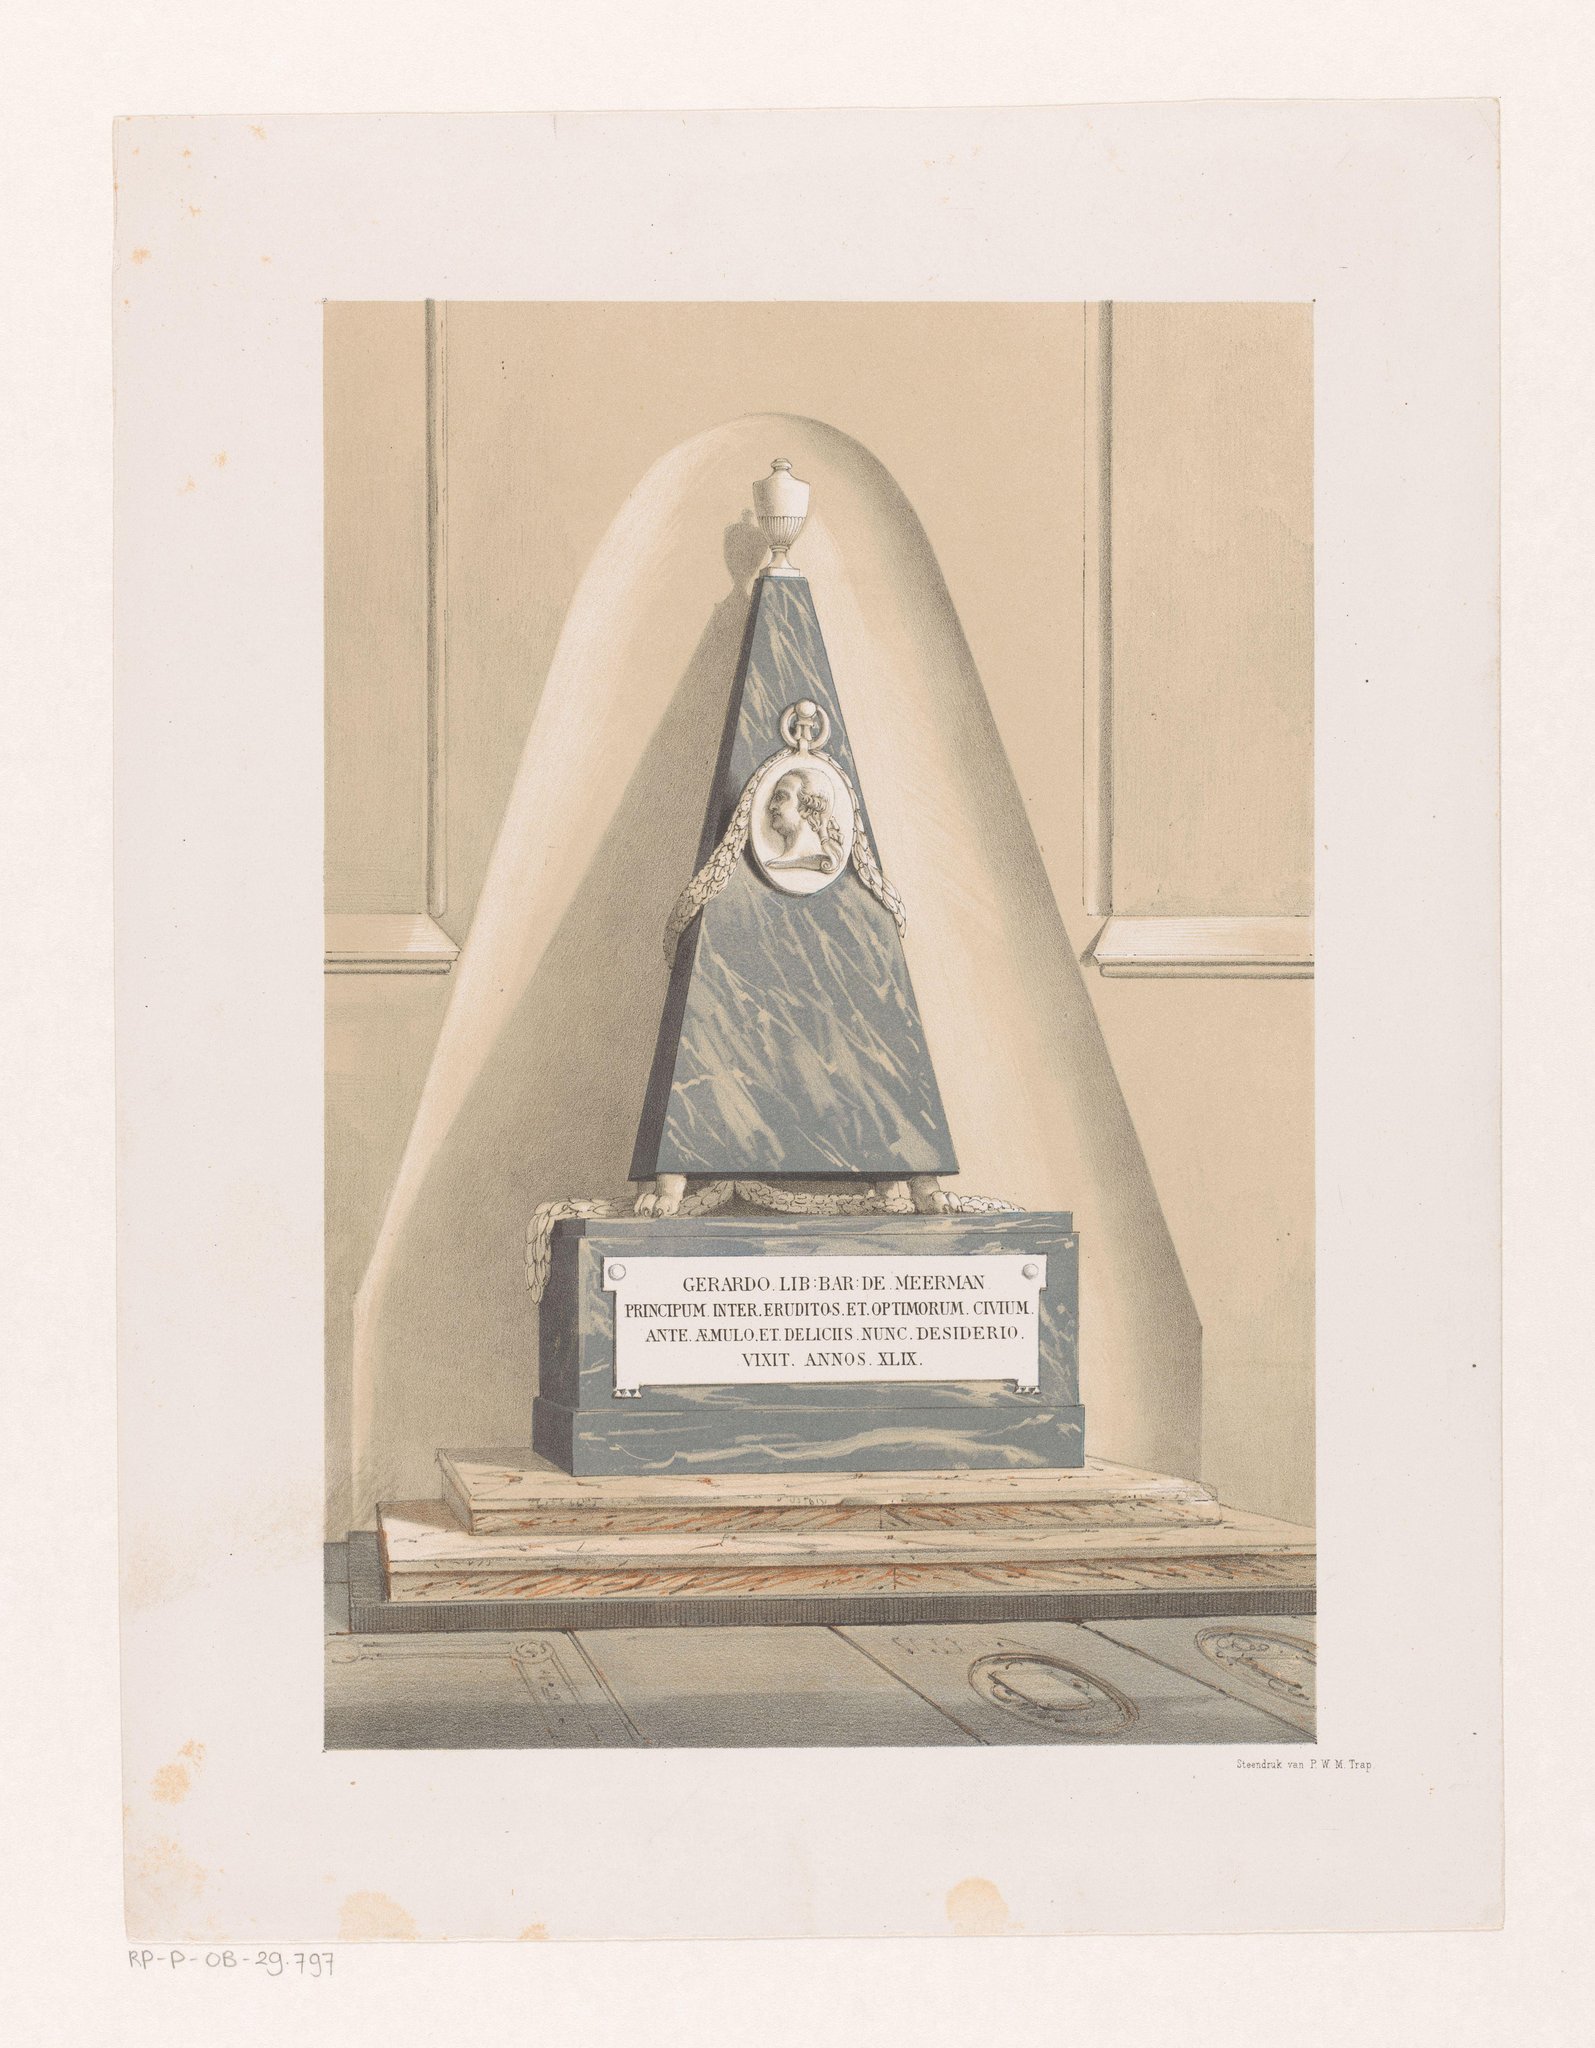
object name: print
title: Grafmonument van Gerard Meerman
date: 1864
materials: paper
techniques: lithograph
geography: leiden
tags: grave, tomb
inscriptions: collector's mark: Lugt 2228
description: Prent uit: Kneppelhout van Sterkenburg, K.J.F.C. De gedenkteekenen in de Pieters-Kerk te Leyden. Leiden: Heuvell, P.H. van den, 1864.